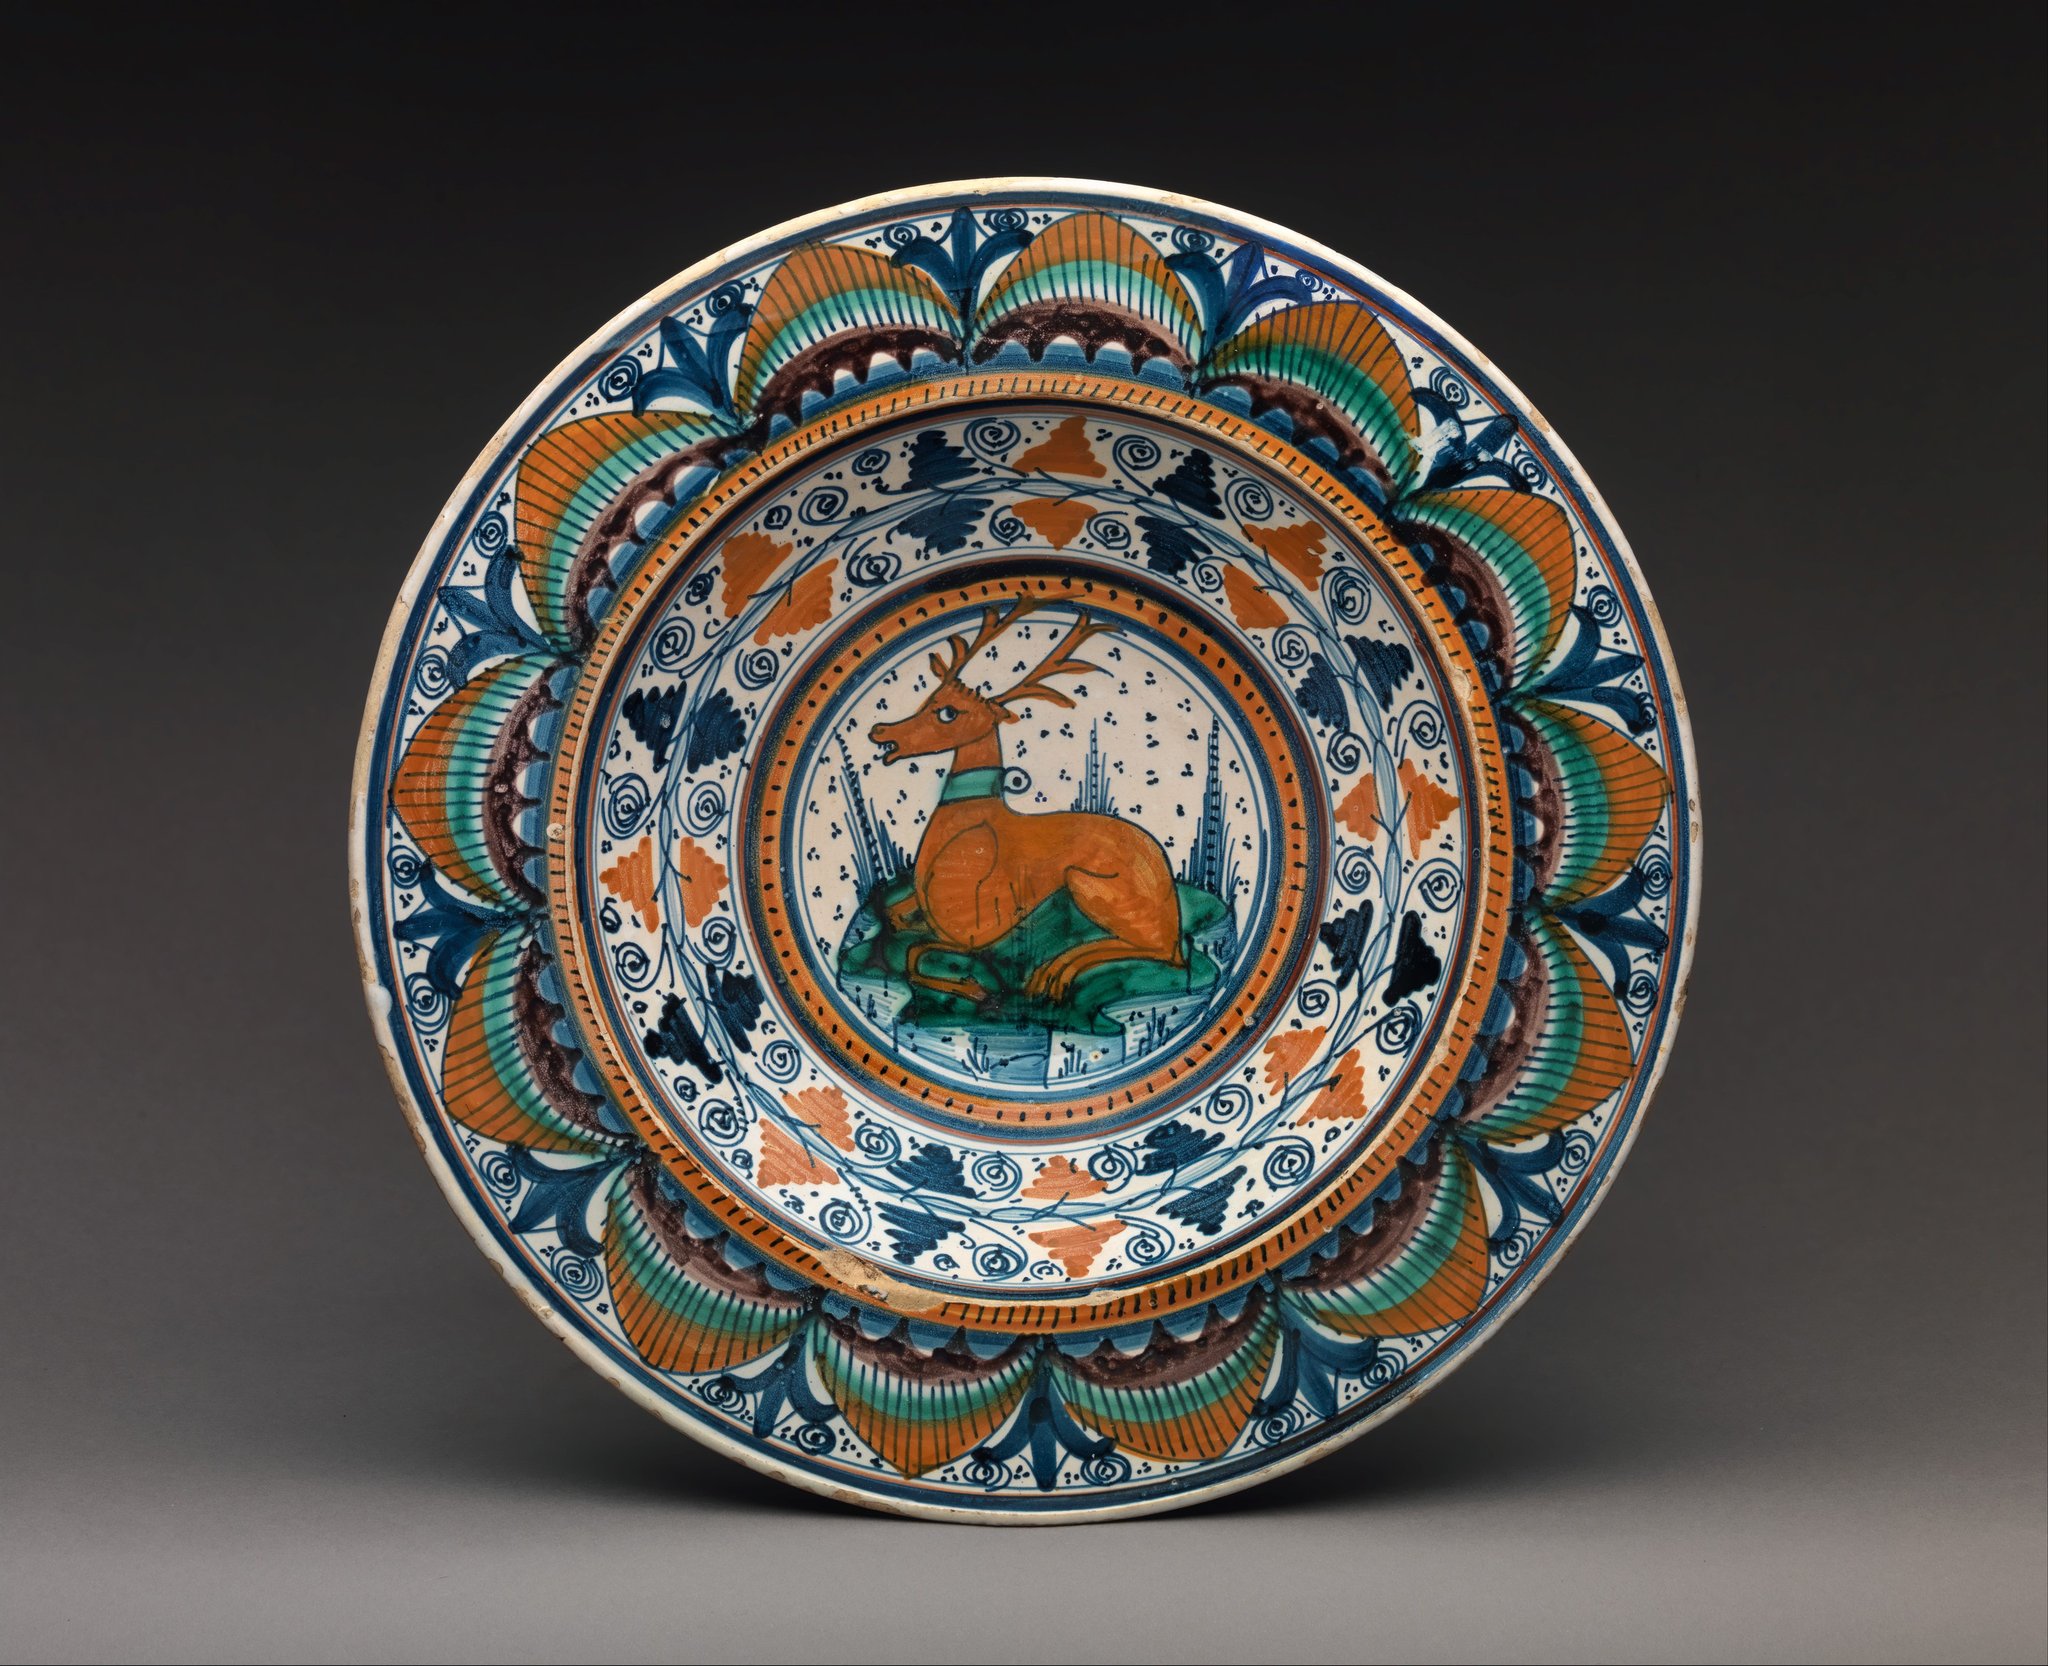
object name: plate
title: Plate with stag resting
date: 1490-1500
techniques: maiolica, glazing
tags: deer